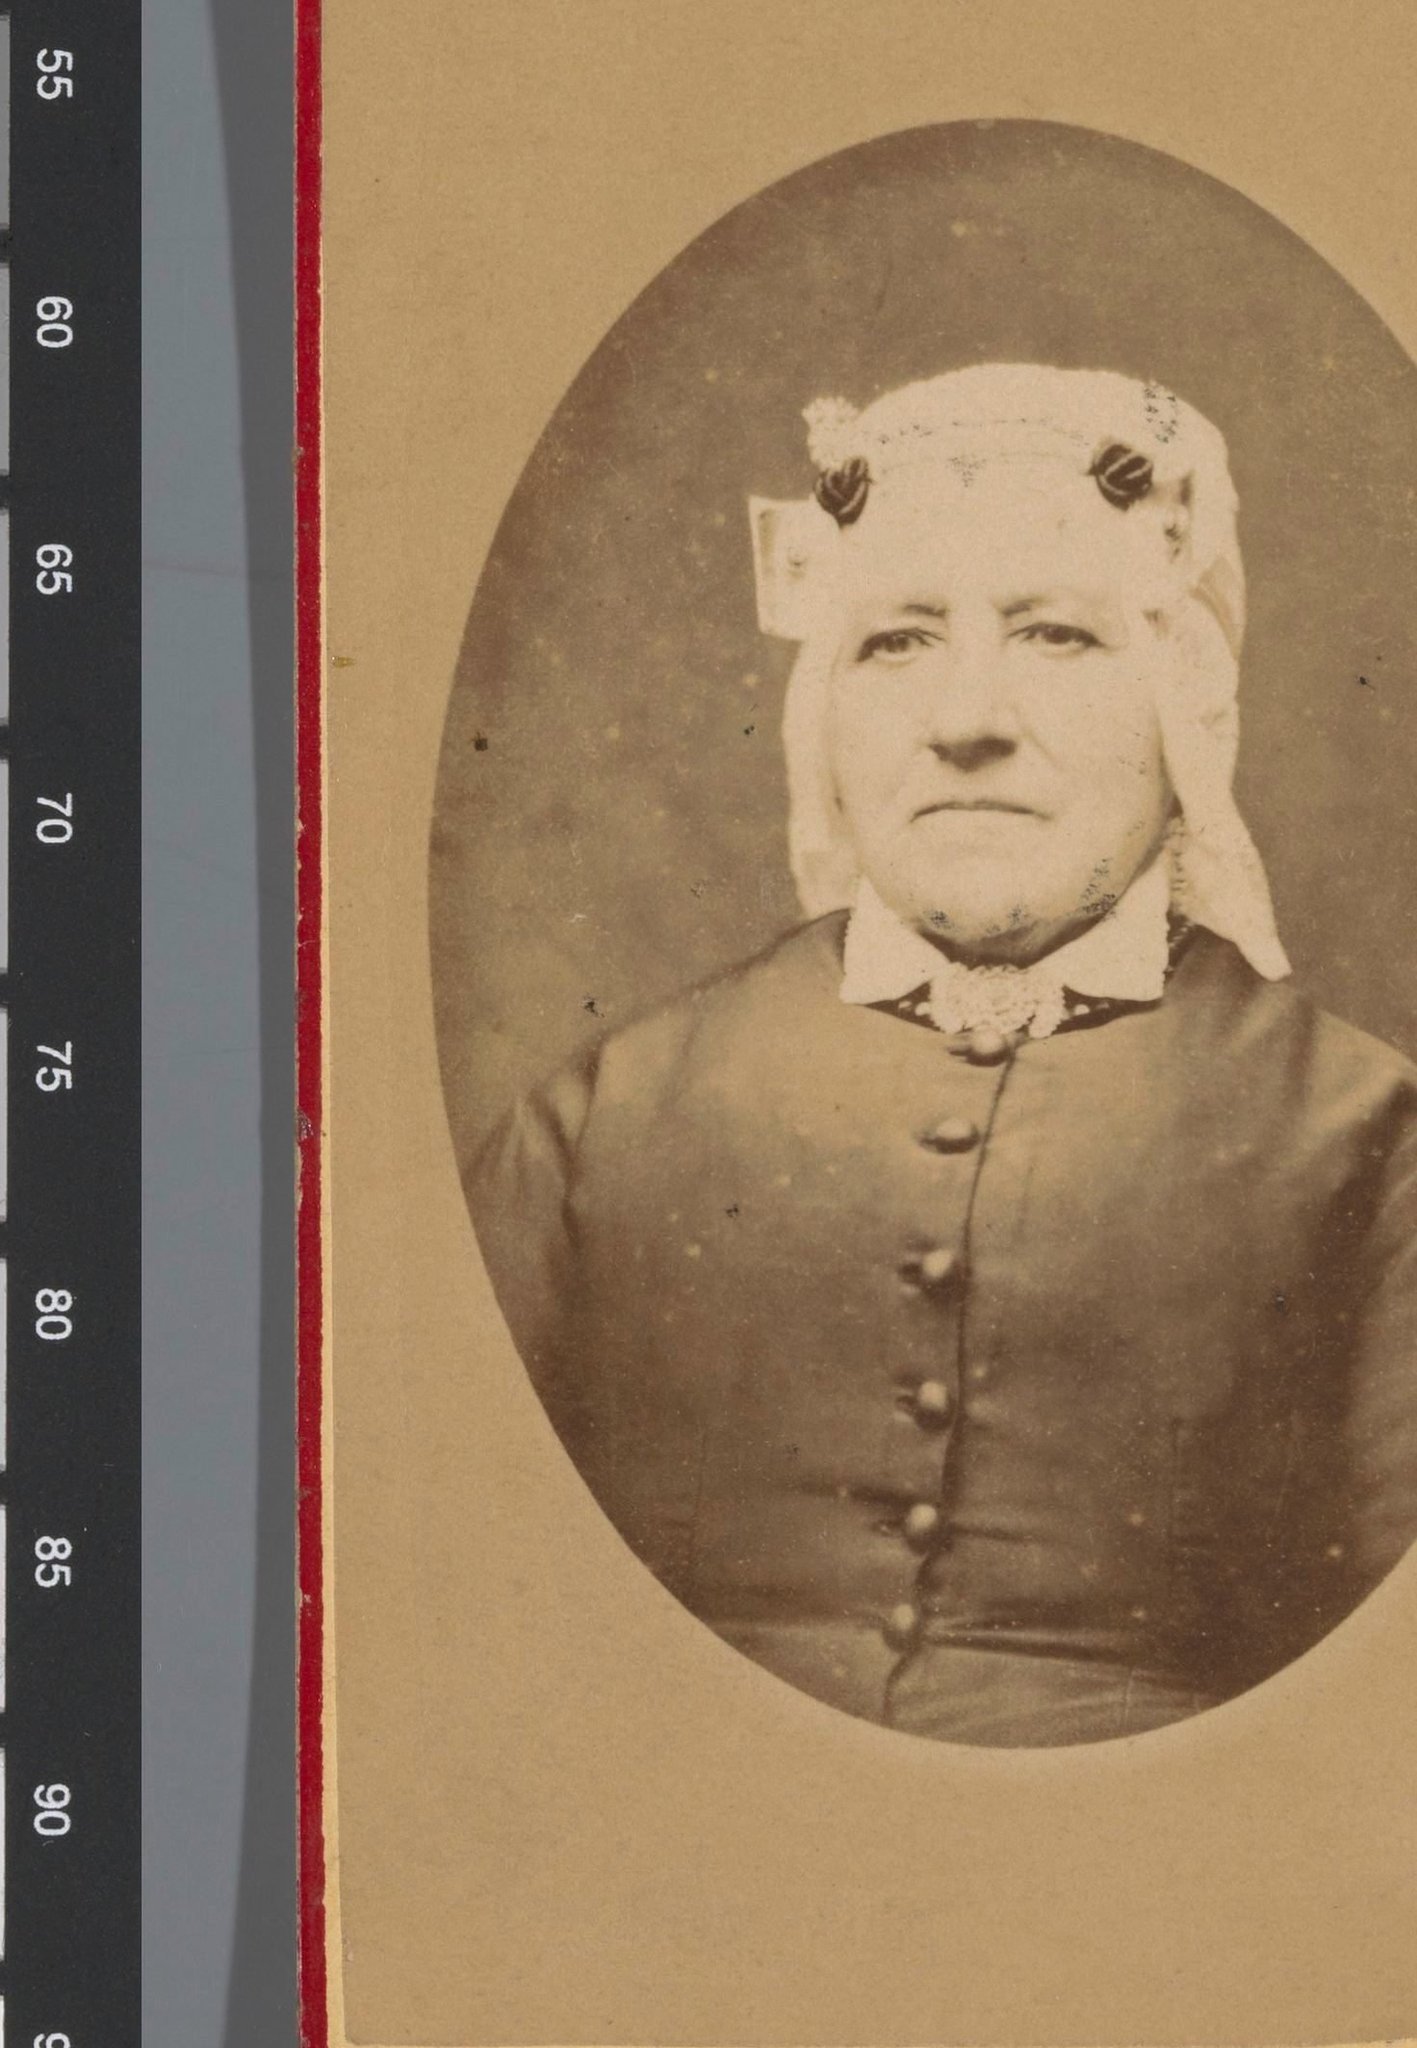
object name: photograph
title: Portret van een onbekende vrouw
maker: jacob swaab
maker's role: fotograaf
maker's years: 1836-1920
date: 1879-1883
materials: cardboard, celluloid, paper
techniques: albumen print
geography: alkmaar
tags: adult woman, anonymous historical person portrayed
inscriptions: address: ‘Hoogstraat No. 2,/ bij de gedempte nieuwsloot/ te/ Alkmaar.’, inscription: ‘Photograaf/ van de wijlen Z. K. H. Prins Hendrik/ der Nederlanden./ Tot nabestelling blijft de plaat bewaard.’